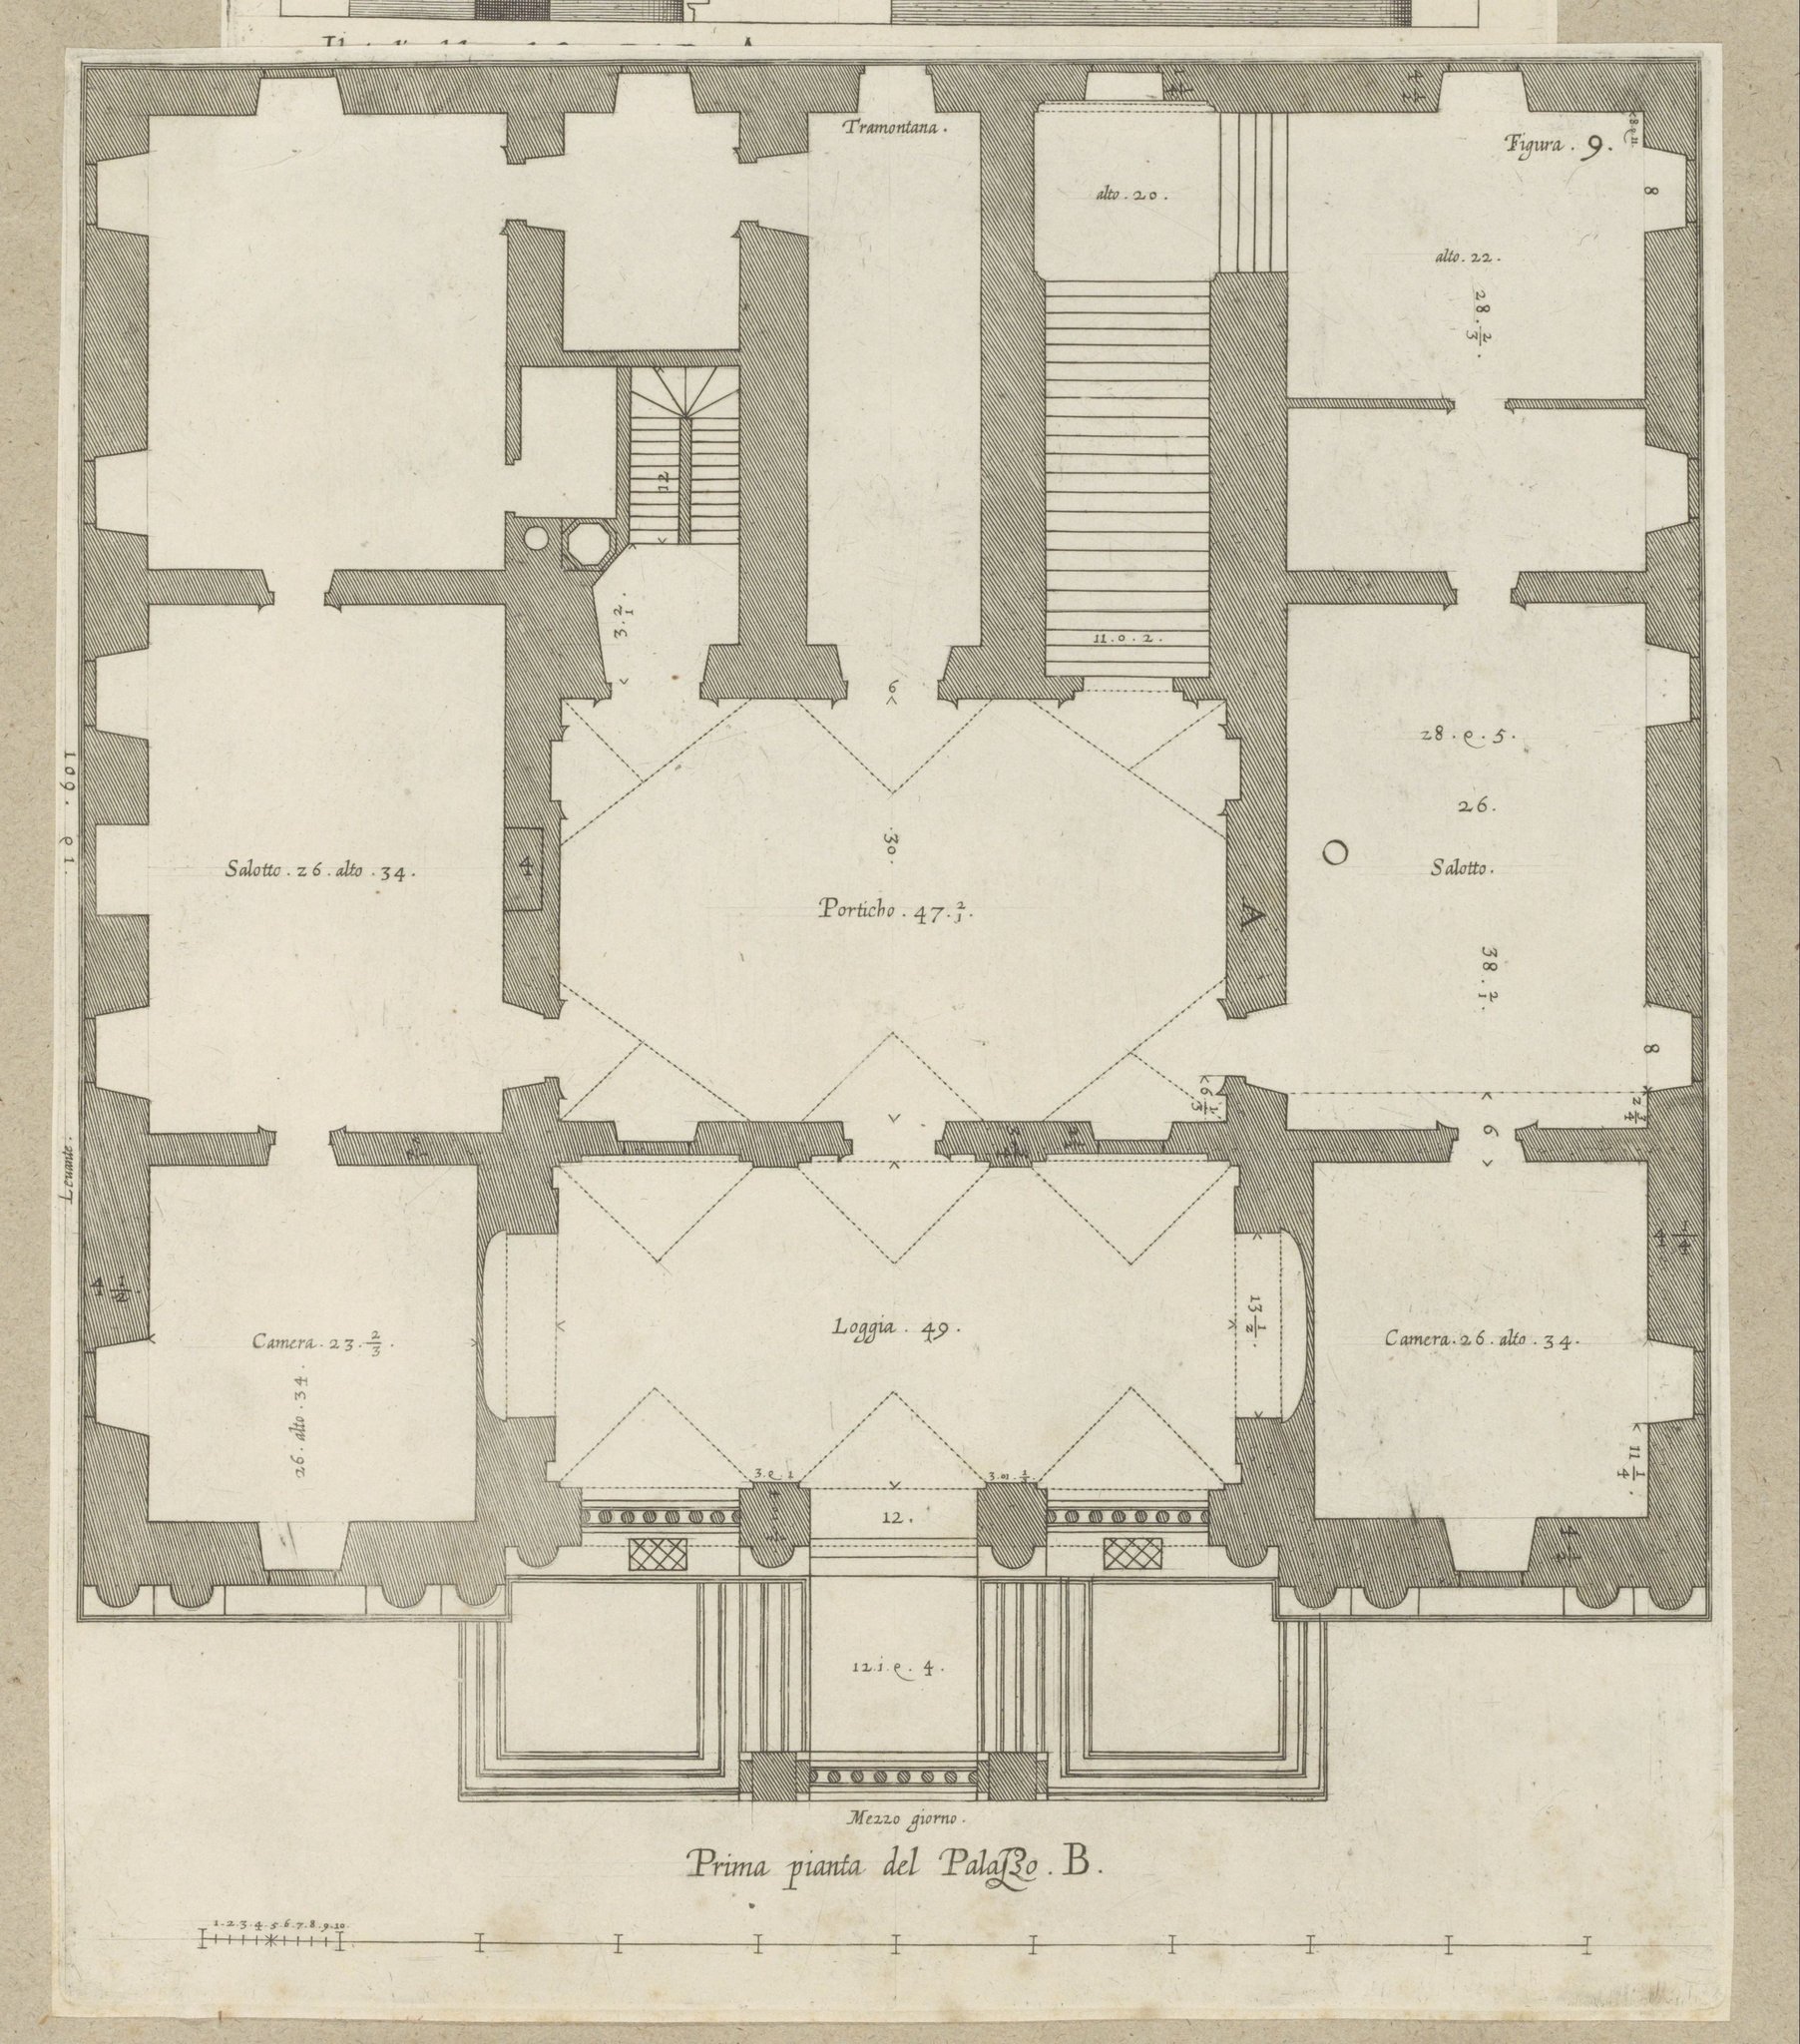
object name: print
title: Plattegrond van de begane grond van de Villa Giustiniani-Cambiaso te Genua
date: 1622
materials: paper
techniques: engraving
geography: antwerp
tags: hôtel, i.e. small palace in city - aa - civic architecture: inside, plan ~ architecture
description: Deze prent maakt deel uit van een album.